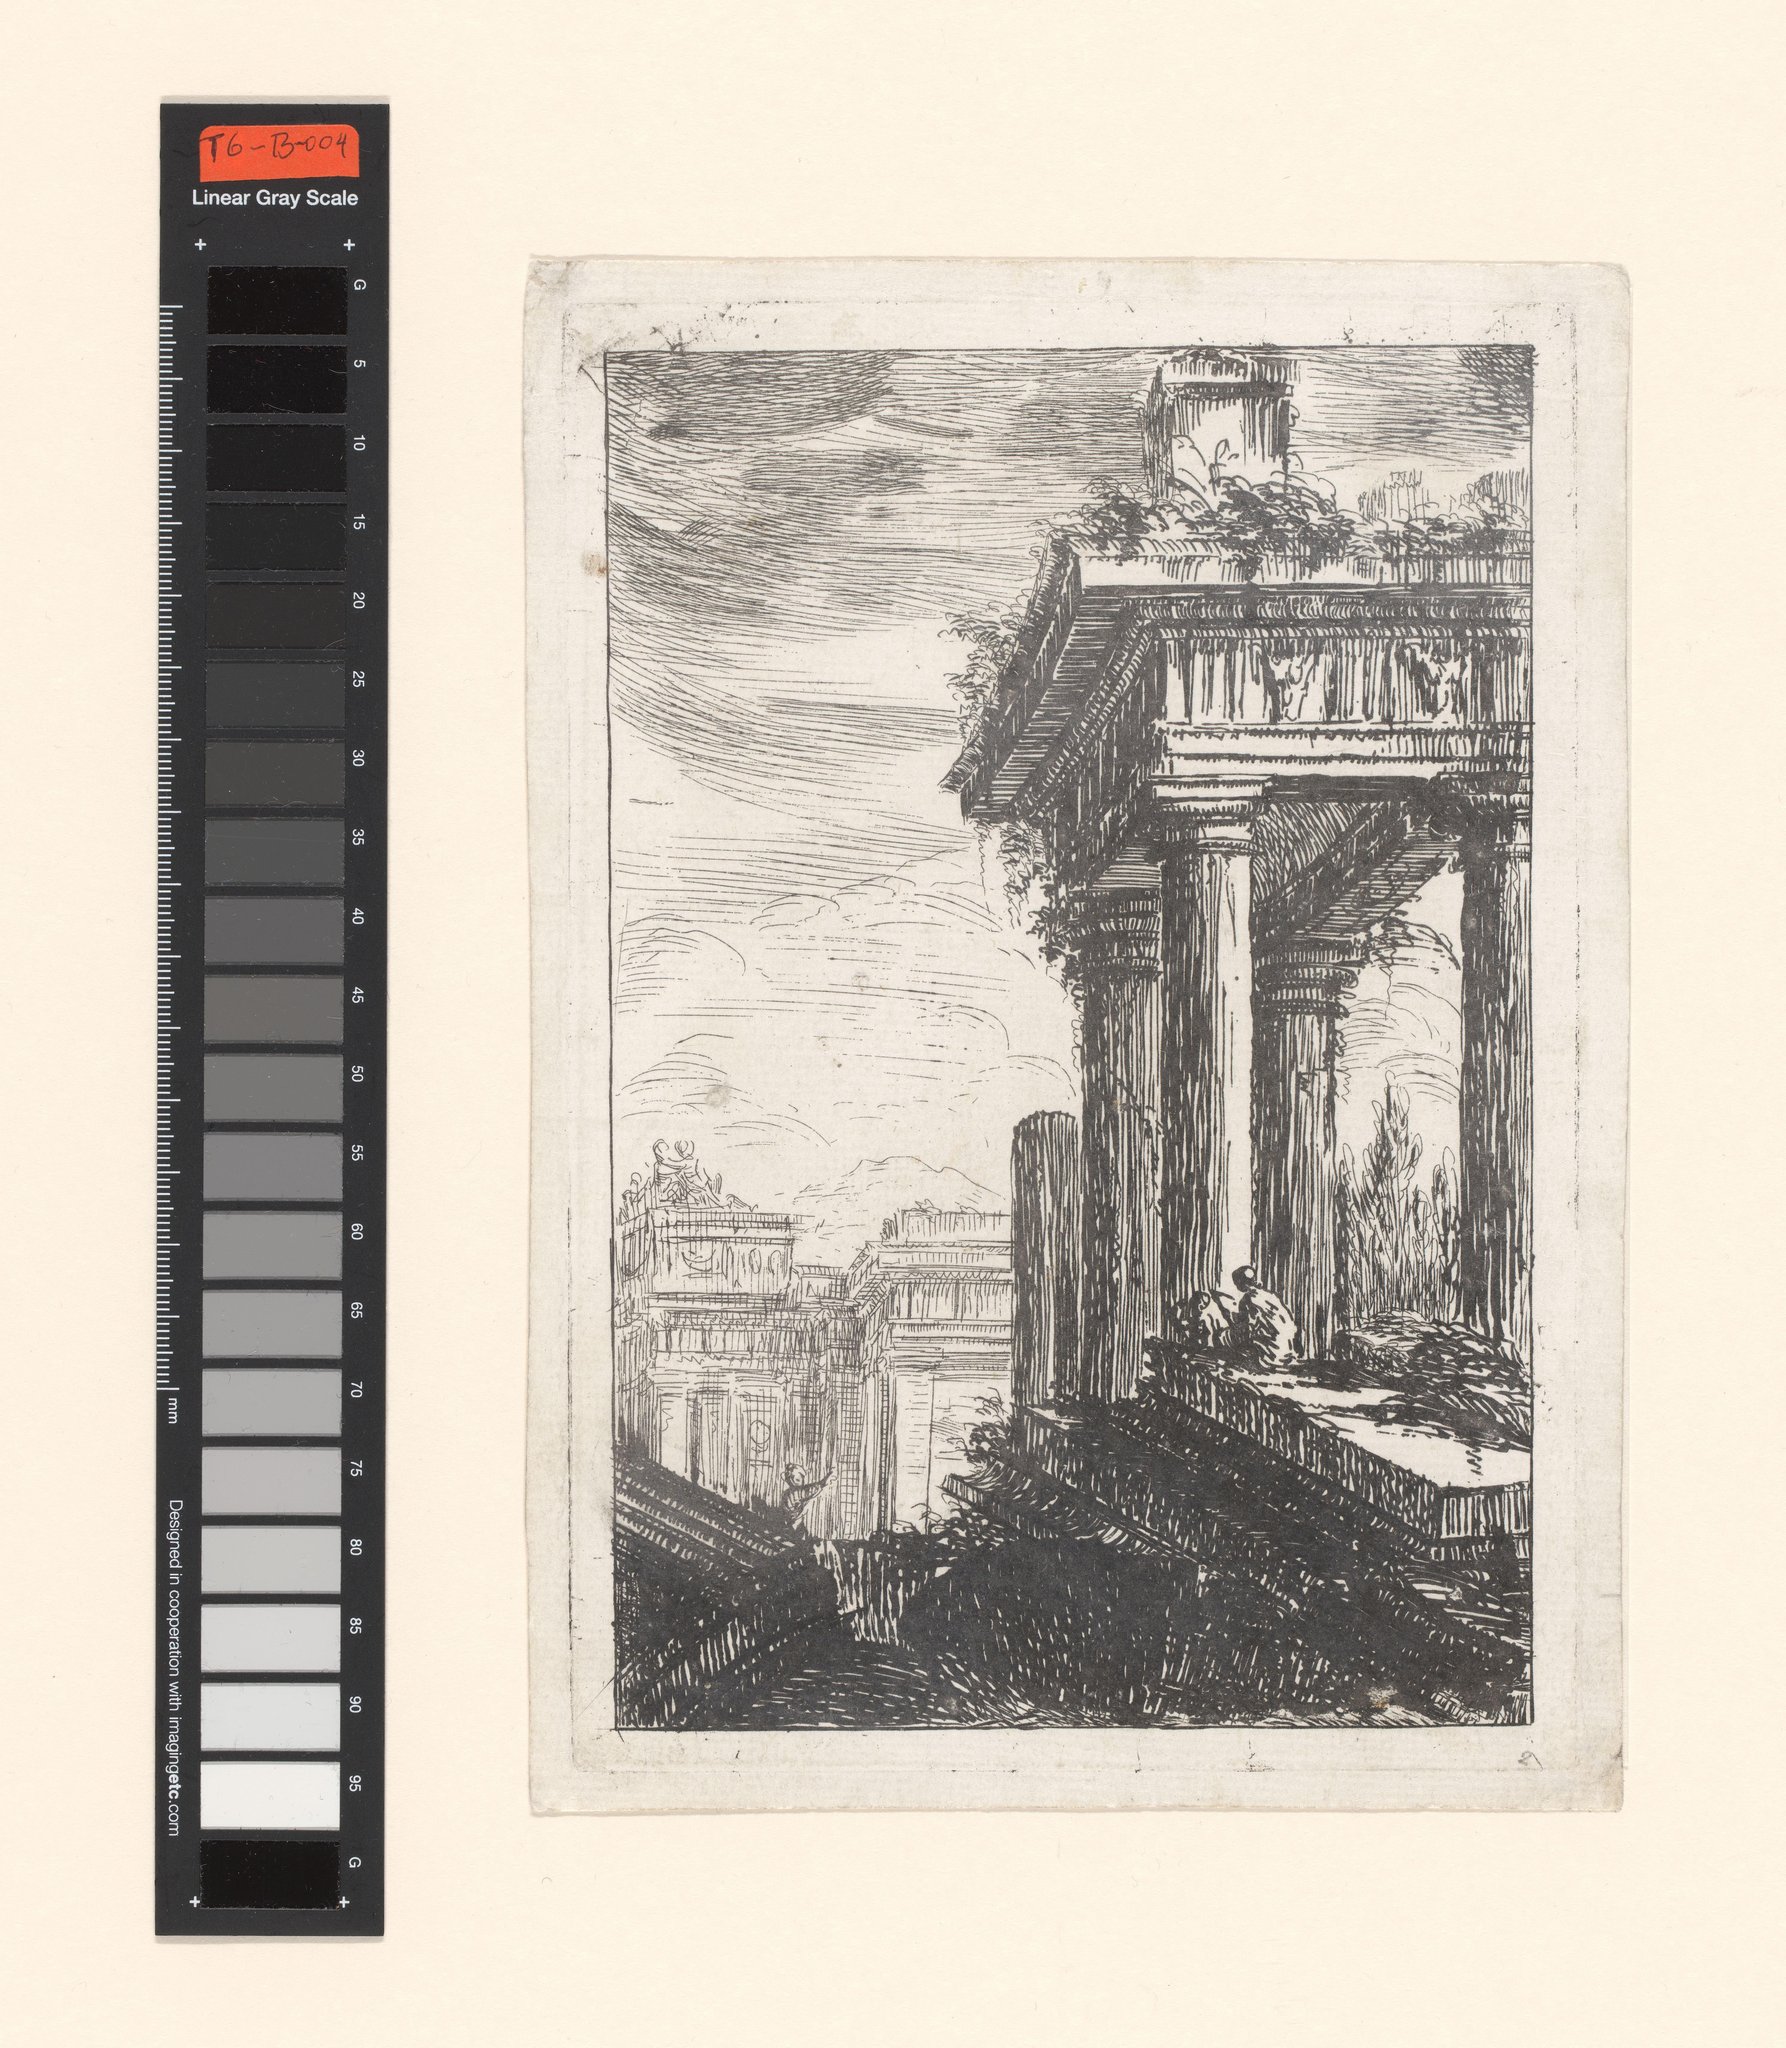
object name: print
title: Cappriccio met tekenaar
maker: gabriel pierre martin dumont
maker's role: print maker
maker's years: 1720-1790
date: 1750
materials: paper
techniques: etching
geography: france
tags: landscape with ruins, draughtsman at work - cc - out of doors, draughtsman studying classical remains - cc - out of doors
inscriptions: collector's mark: Lugt 2760, collector's mark: Lugt 2228